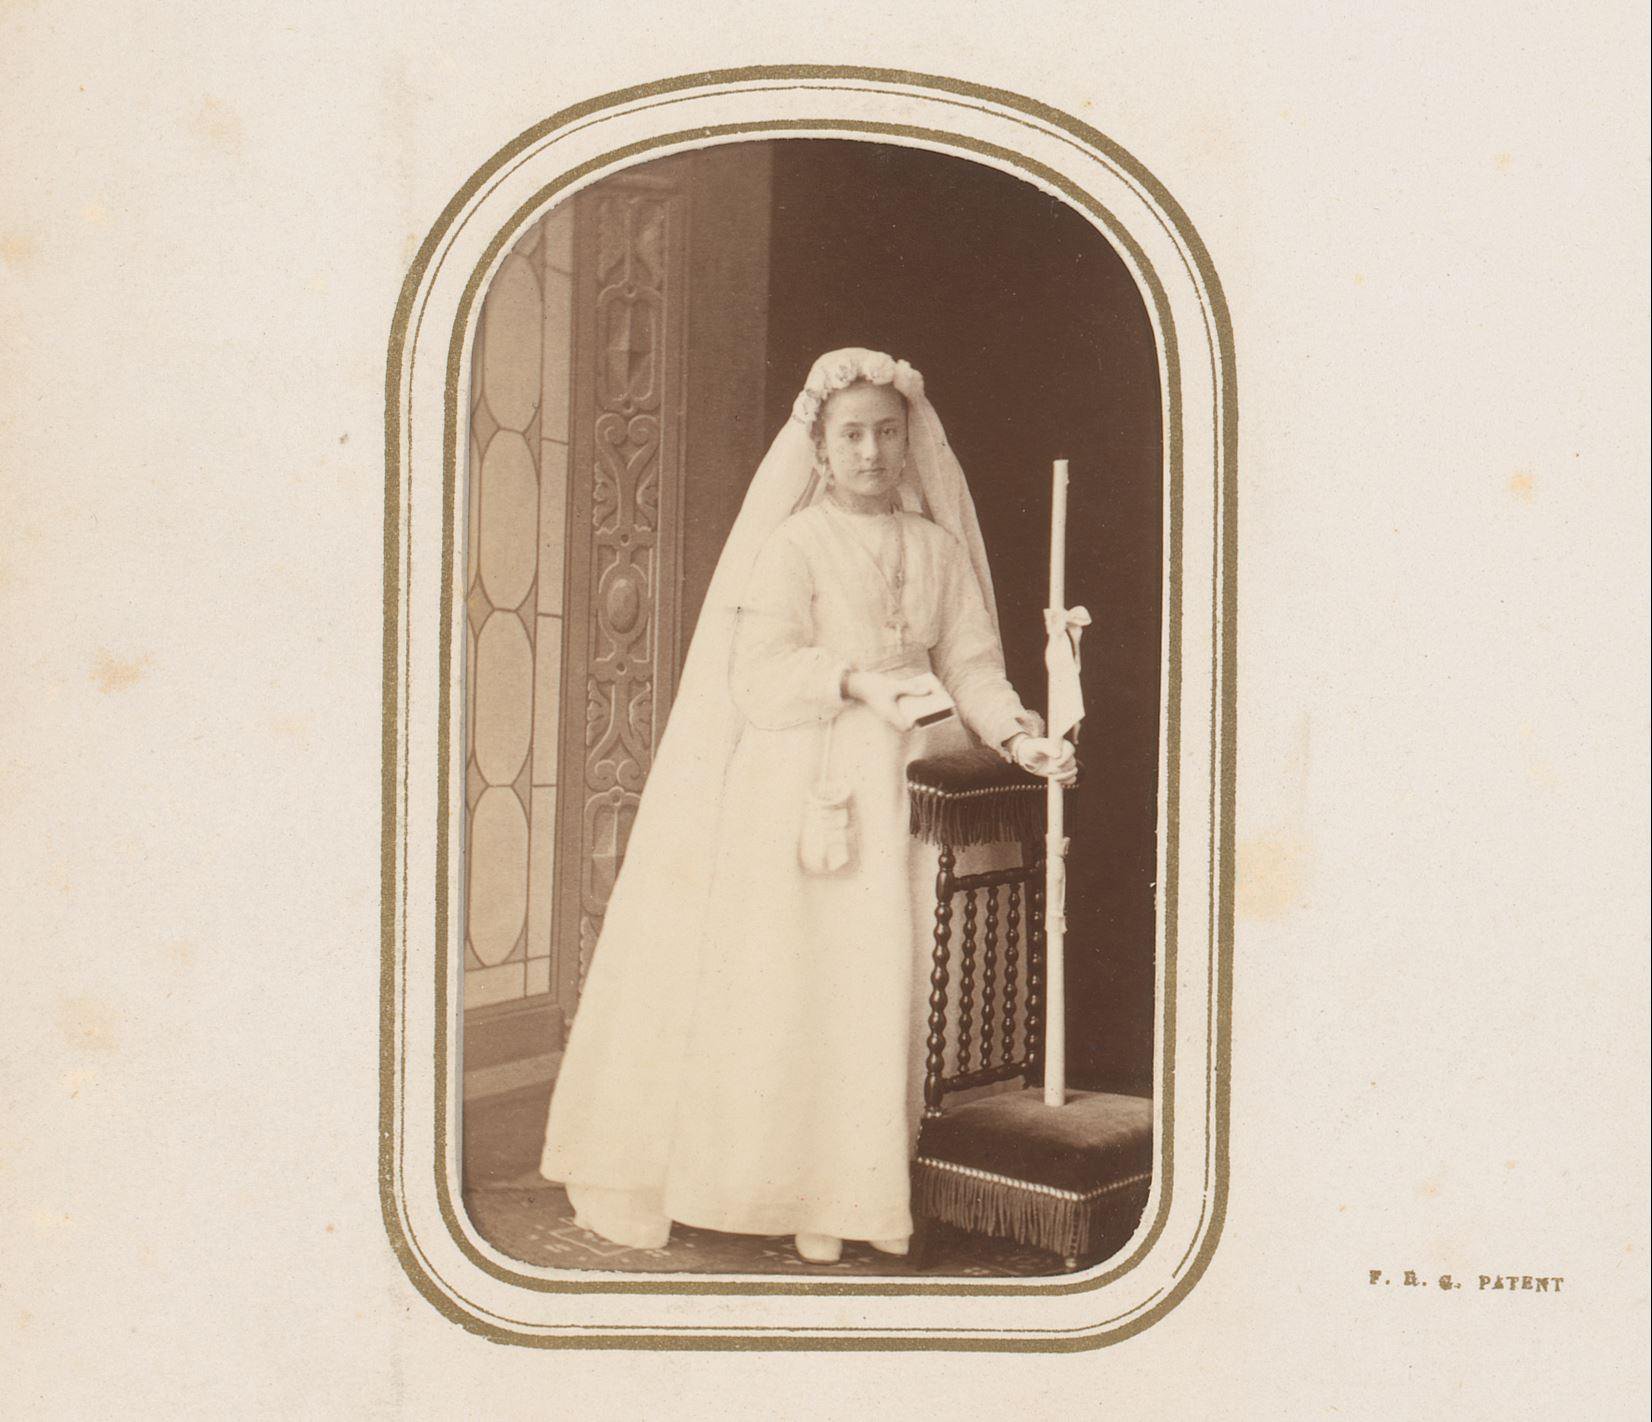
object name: album leaf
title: Portret van een meisje in een communiejurk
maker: louis sauvager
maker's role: fotograaf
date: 1850-1890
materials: cardboard, photographic support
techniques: albumen print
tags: communion dress, historical persons, girl (child between toddler and youth)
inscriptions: inscription: ‘Fontainebleau/ Grand Rue 201/ Phtotographie/ L. Sauvager/ (...)’